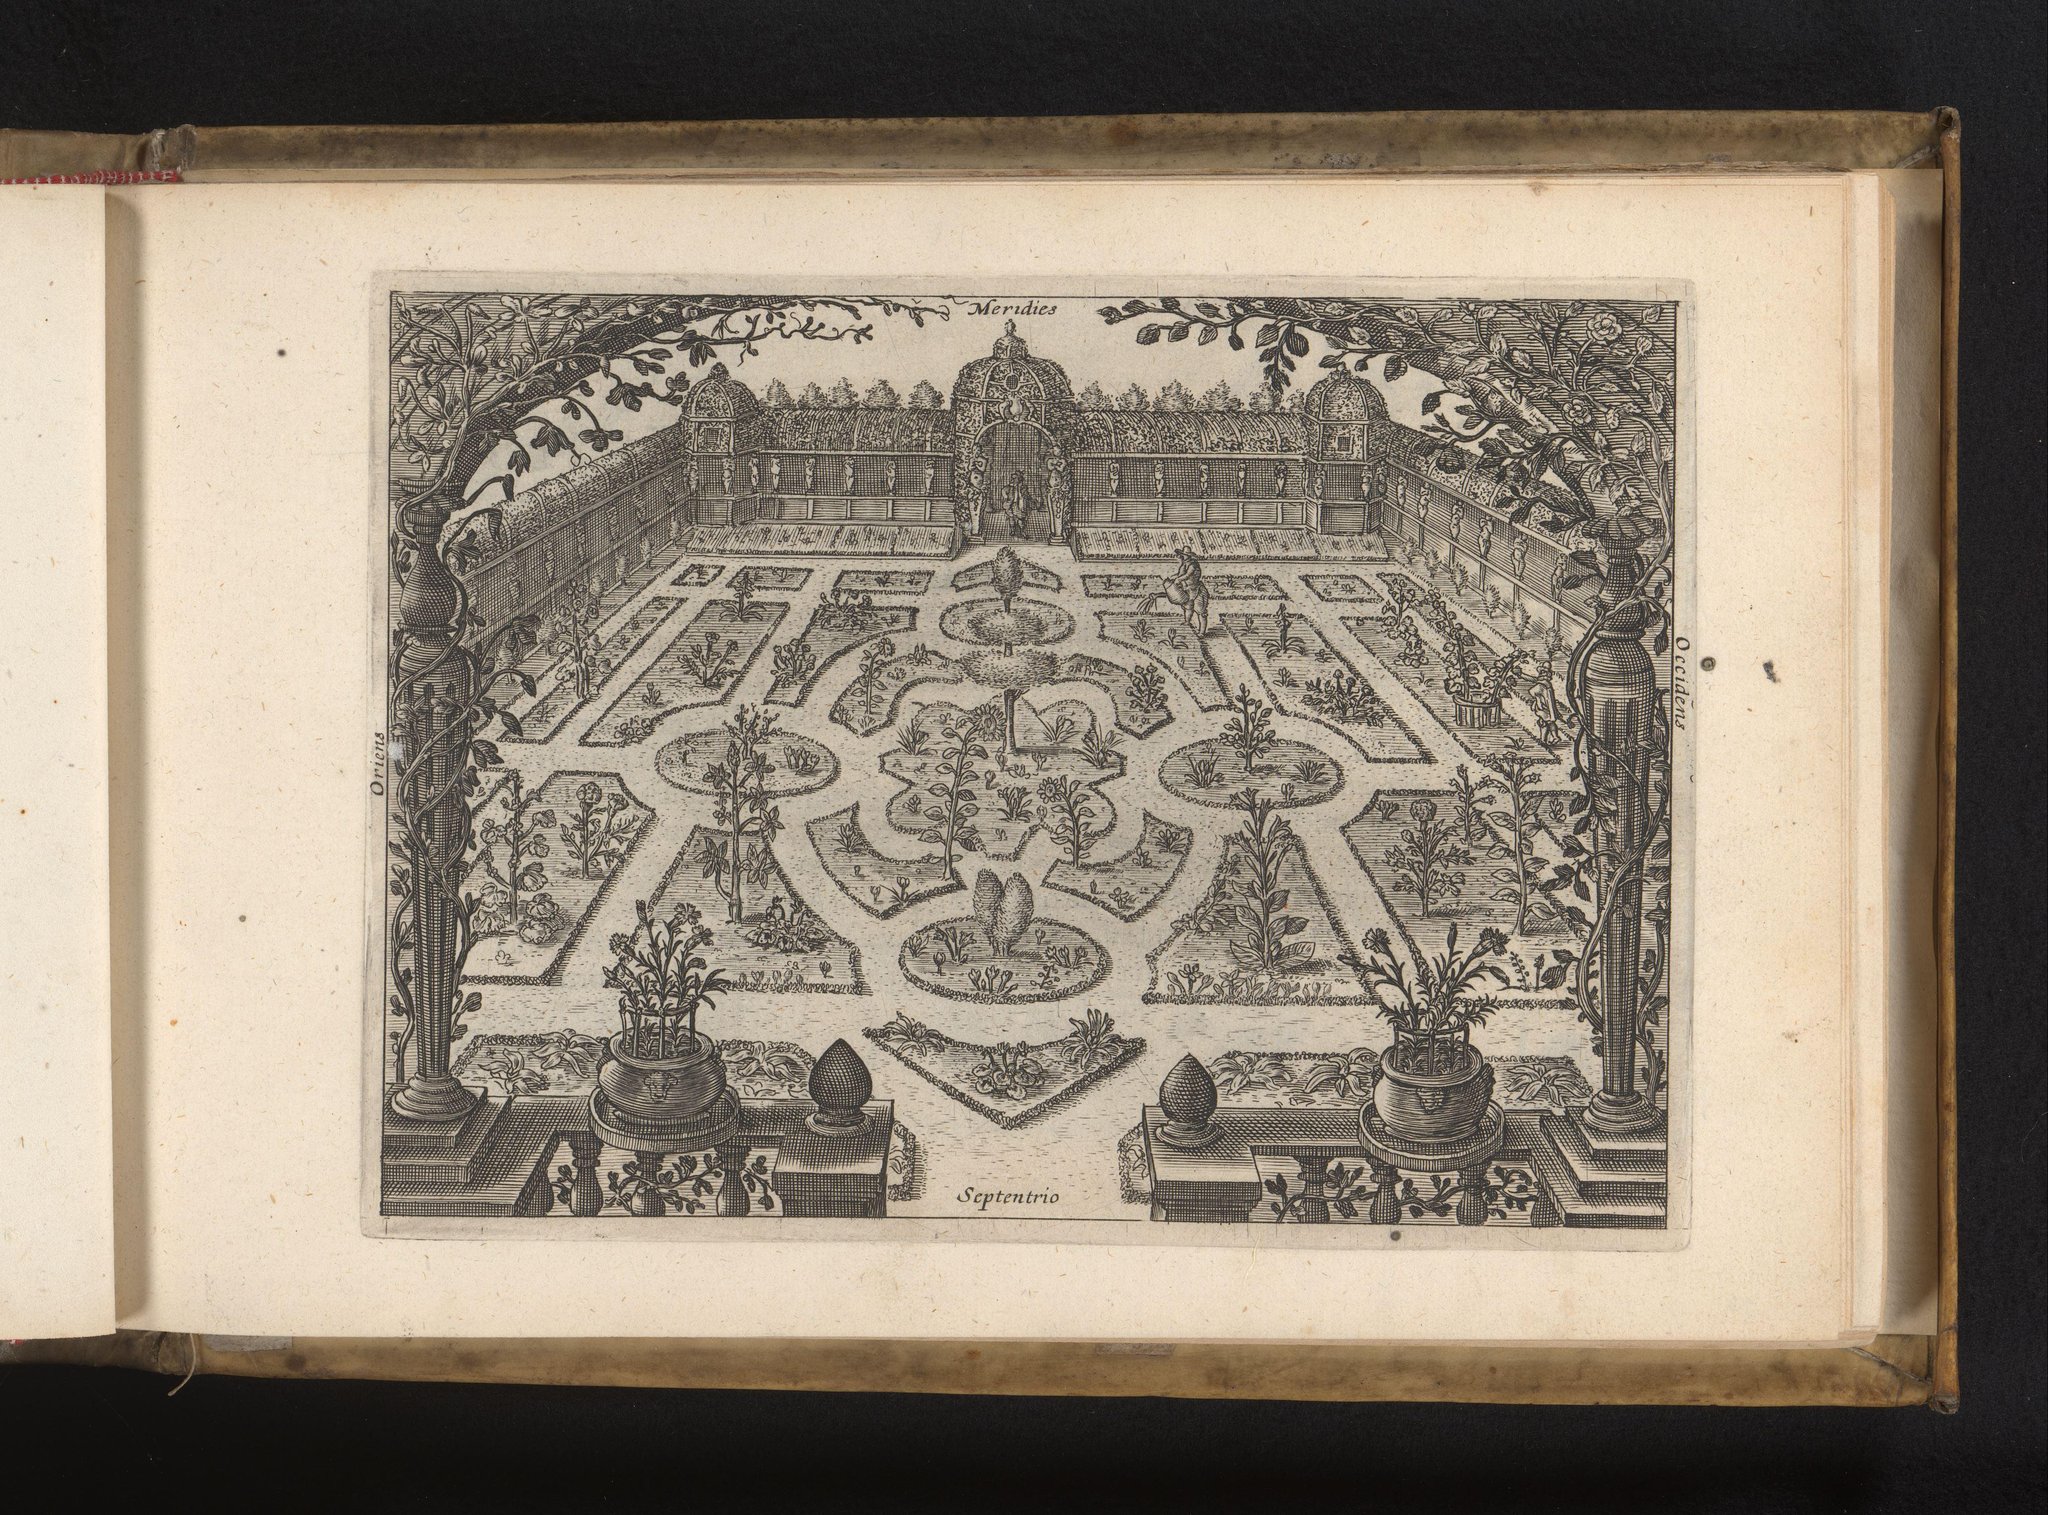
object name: page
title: Bloementuin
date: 1617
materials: paper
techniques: engraving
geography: utrecht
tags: garden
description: Prent uit: Passe, Crispijn van de (II). Hortus floridus in quo rariorum & minus vulgarium florum icones ad vivam veramque formam. Arnhem: Johannes Janssonius, 1617.